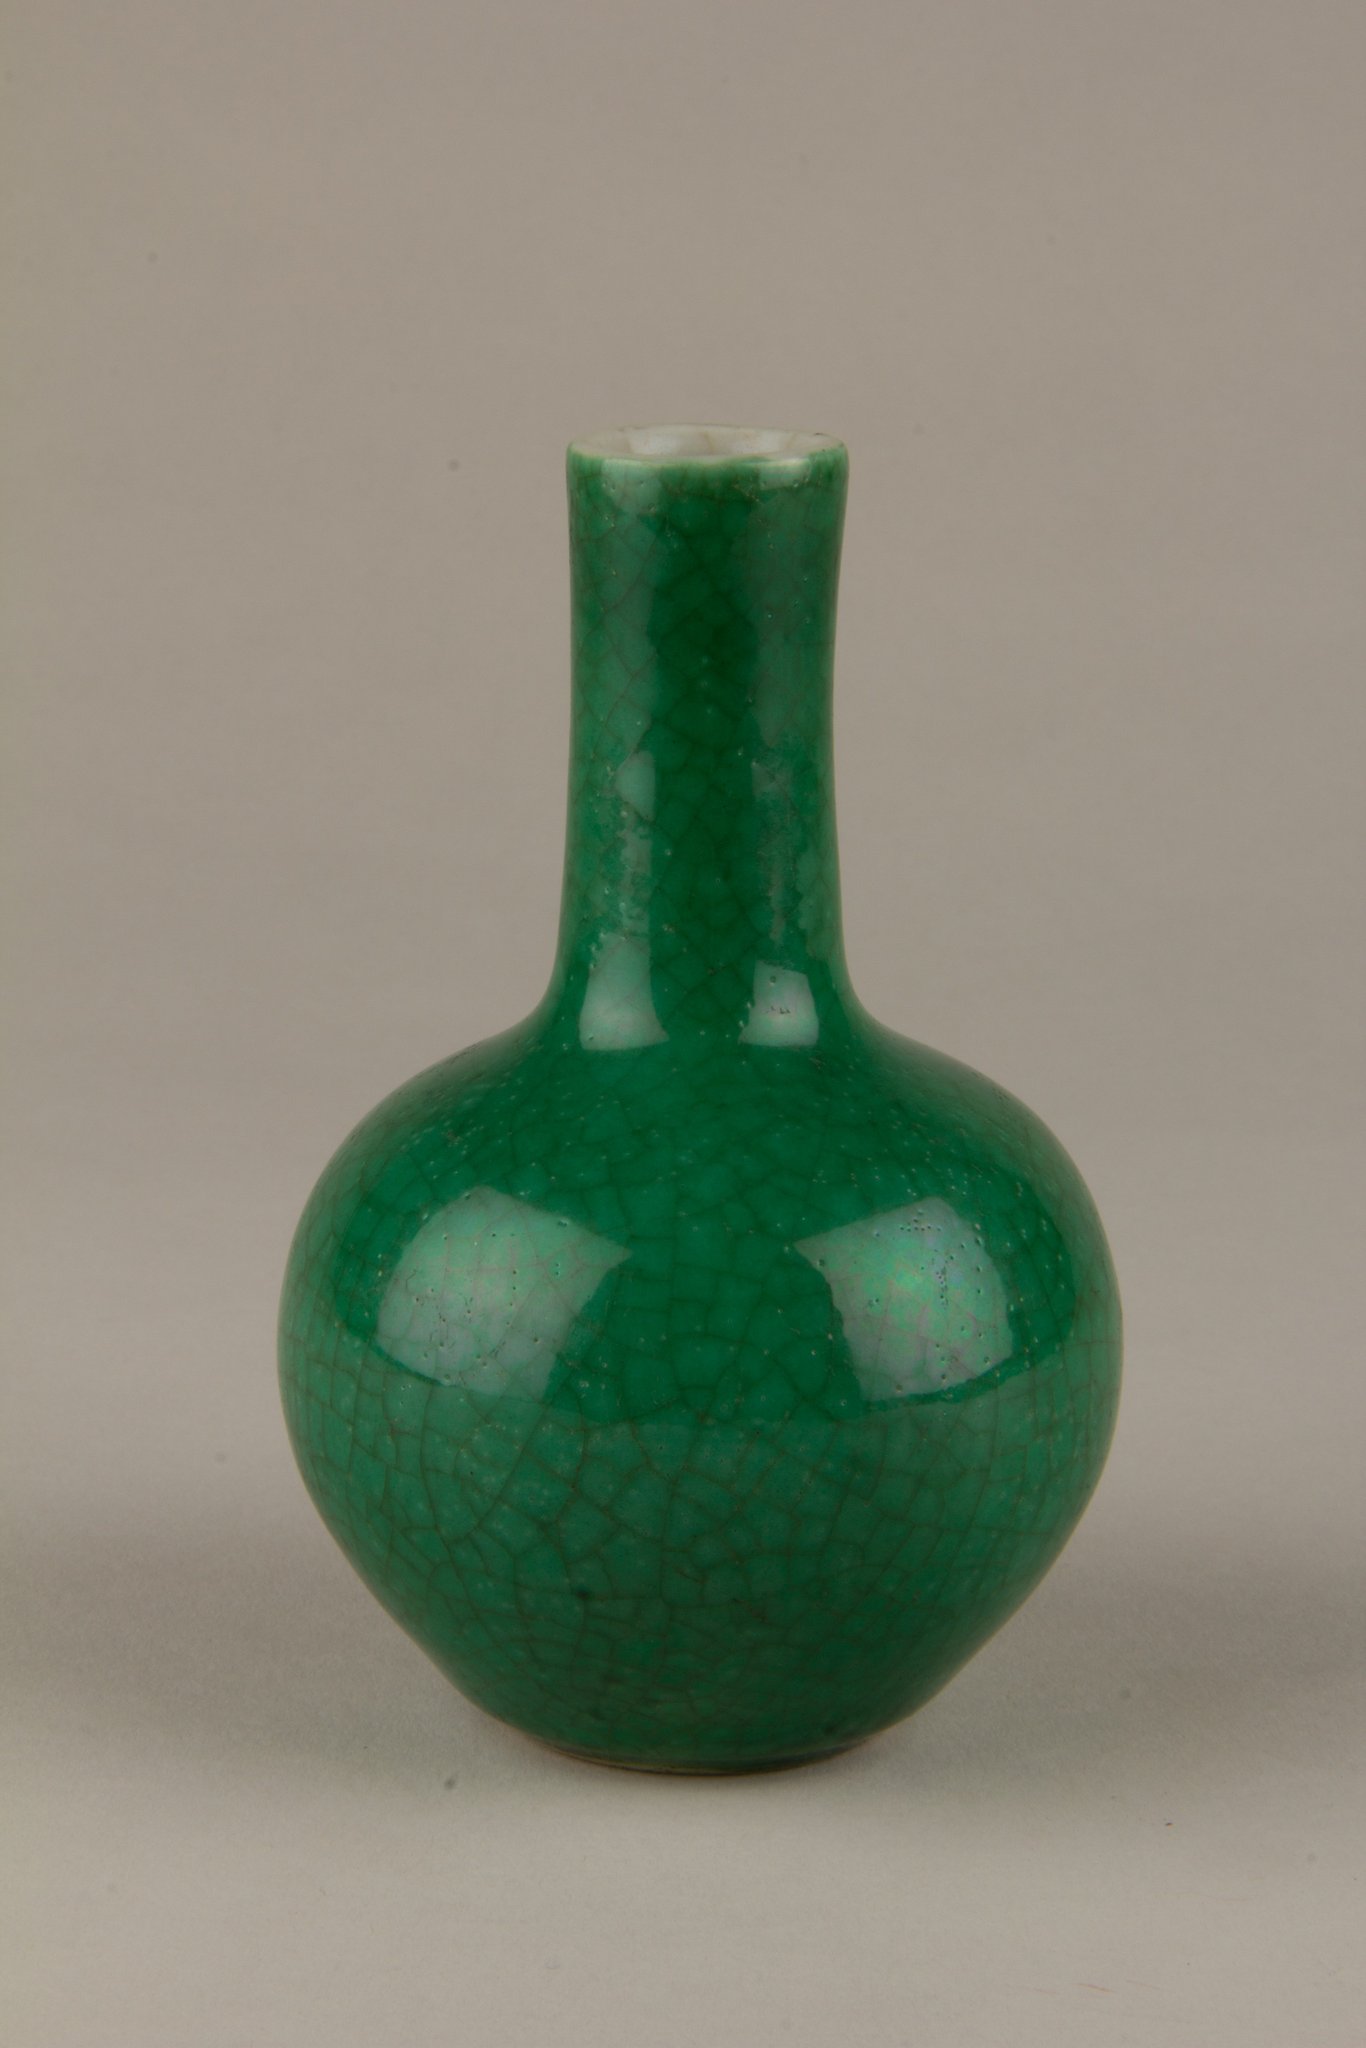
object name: bottle vase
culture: chinese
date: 1701-1733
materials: glaze, porcelain